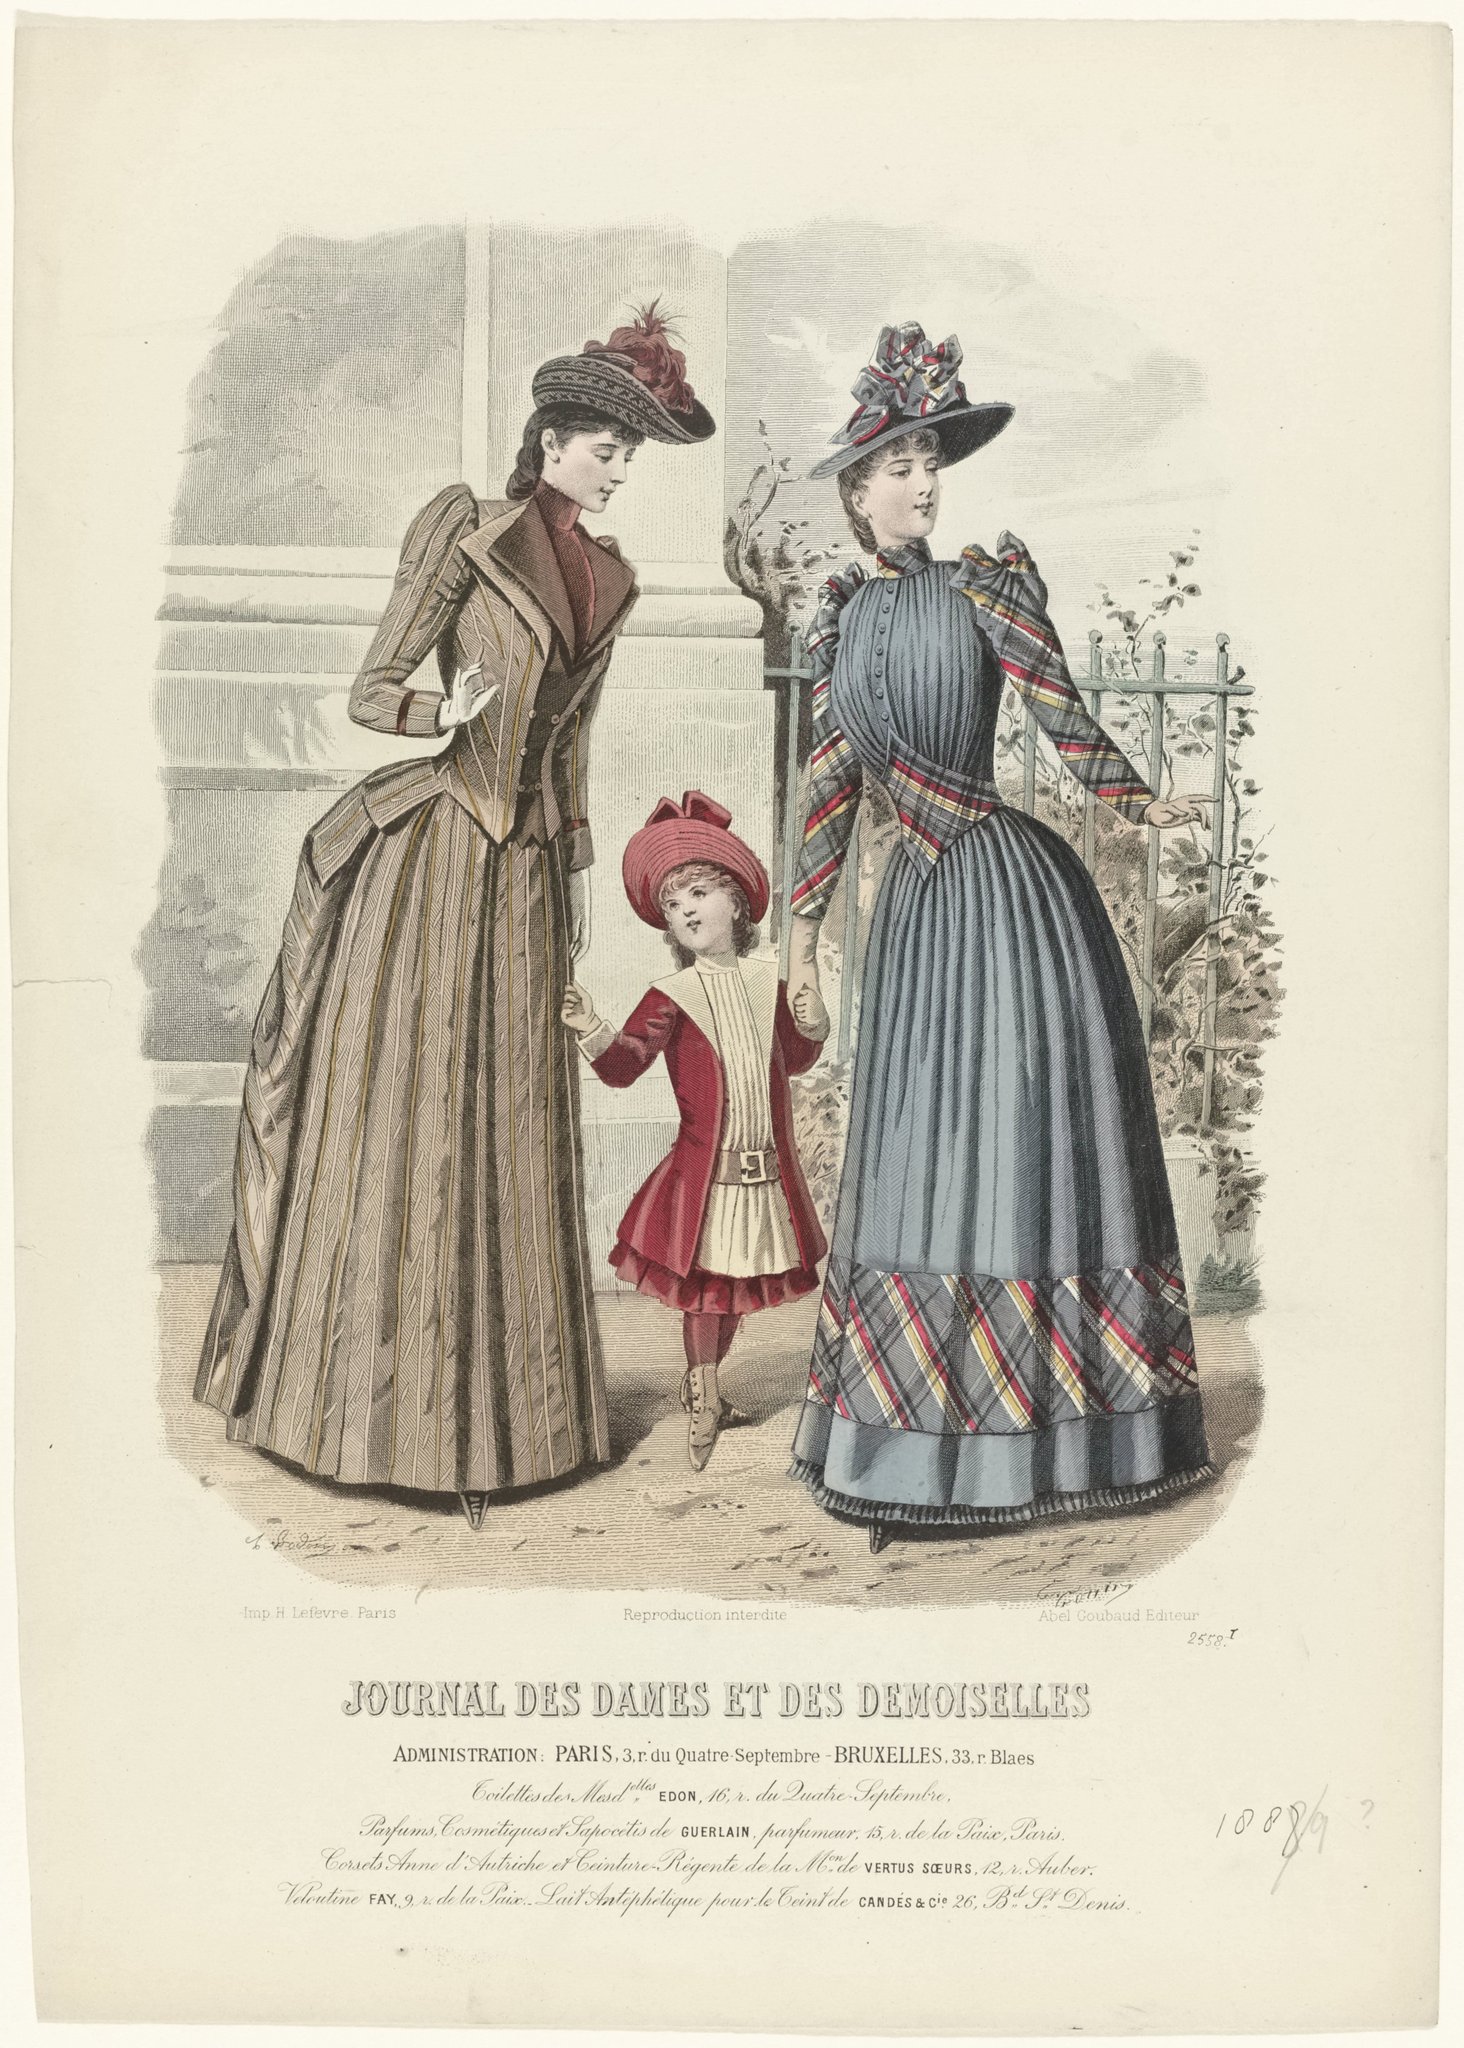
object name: fashion print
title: Journal des Dames et des Demoiselles, 1888-1889, No. 2558: Toilettes de Mesd.elles EDON (...)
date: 1888-1889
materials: paper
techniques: engraving, hand coloring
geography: paris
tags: skirt (+ girls' clothes), head-gear: hat (+ girls' clothes), belt, girdle, waistband (+ girls' clothes), boots (+ girls' clothes), coat (+ girls' clothes), fence, wall, paling, fashion plates, head-gear: hat (+ women's clothes), dress, gown (+ women's clothes)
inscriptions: title: ‘JOURNAL DES DAMES ET DES DEMOISELLES’, address: ‘ADMINISTRATION: PARIS, 3,r. du Quatre-Septembre-BRUXELLES, 33, r. Blaes’, caption: ‘Toilettes des Mesd.elles EDON, 16, r. du Quatre-Septembre. Parfums, Cosmétiques et Sapocétis de GUERLAIN, parfumeur, 15, r. de la Paix, Paris. Corsets Anne d'Autriche et Ceinture-Régente de la M.on de VERTUS SOEURS, 12, r. Auber. Veloutine FAY, 9, r. de la Paix. Lait Antéphélique pour le Teint de CANDÉS & CIE, 26, B.d S.t Denis.’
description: Twee vrouwen en een meisje bij een gebouw met hekwerk. Volgens het onderschrift: 'toilettes' van Edon. Hieronder enkele regels reclametekst voor verschillende producten. Prent uit het modetijdschrift Journal des Dames et des Demoiselles (1852-1902).